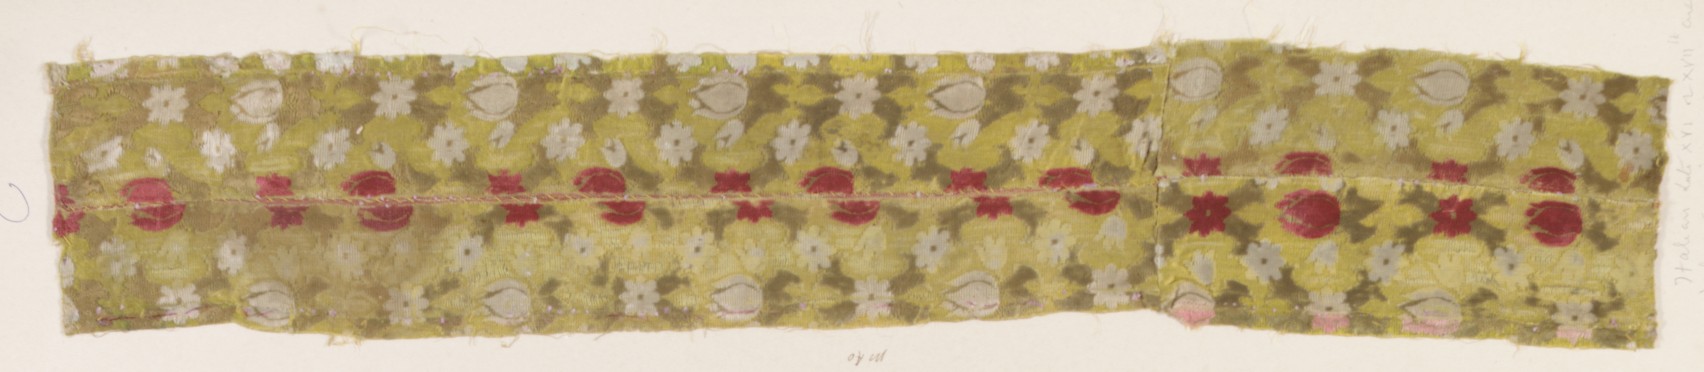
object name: fragment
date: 1701-1800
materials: silk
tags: flowers,leaves